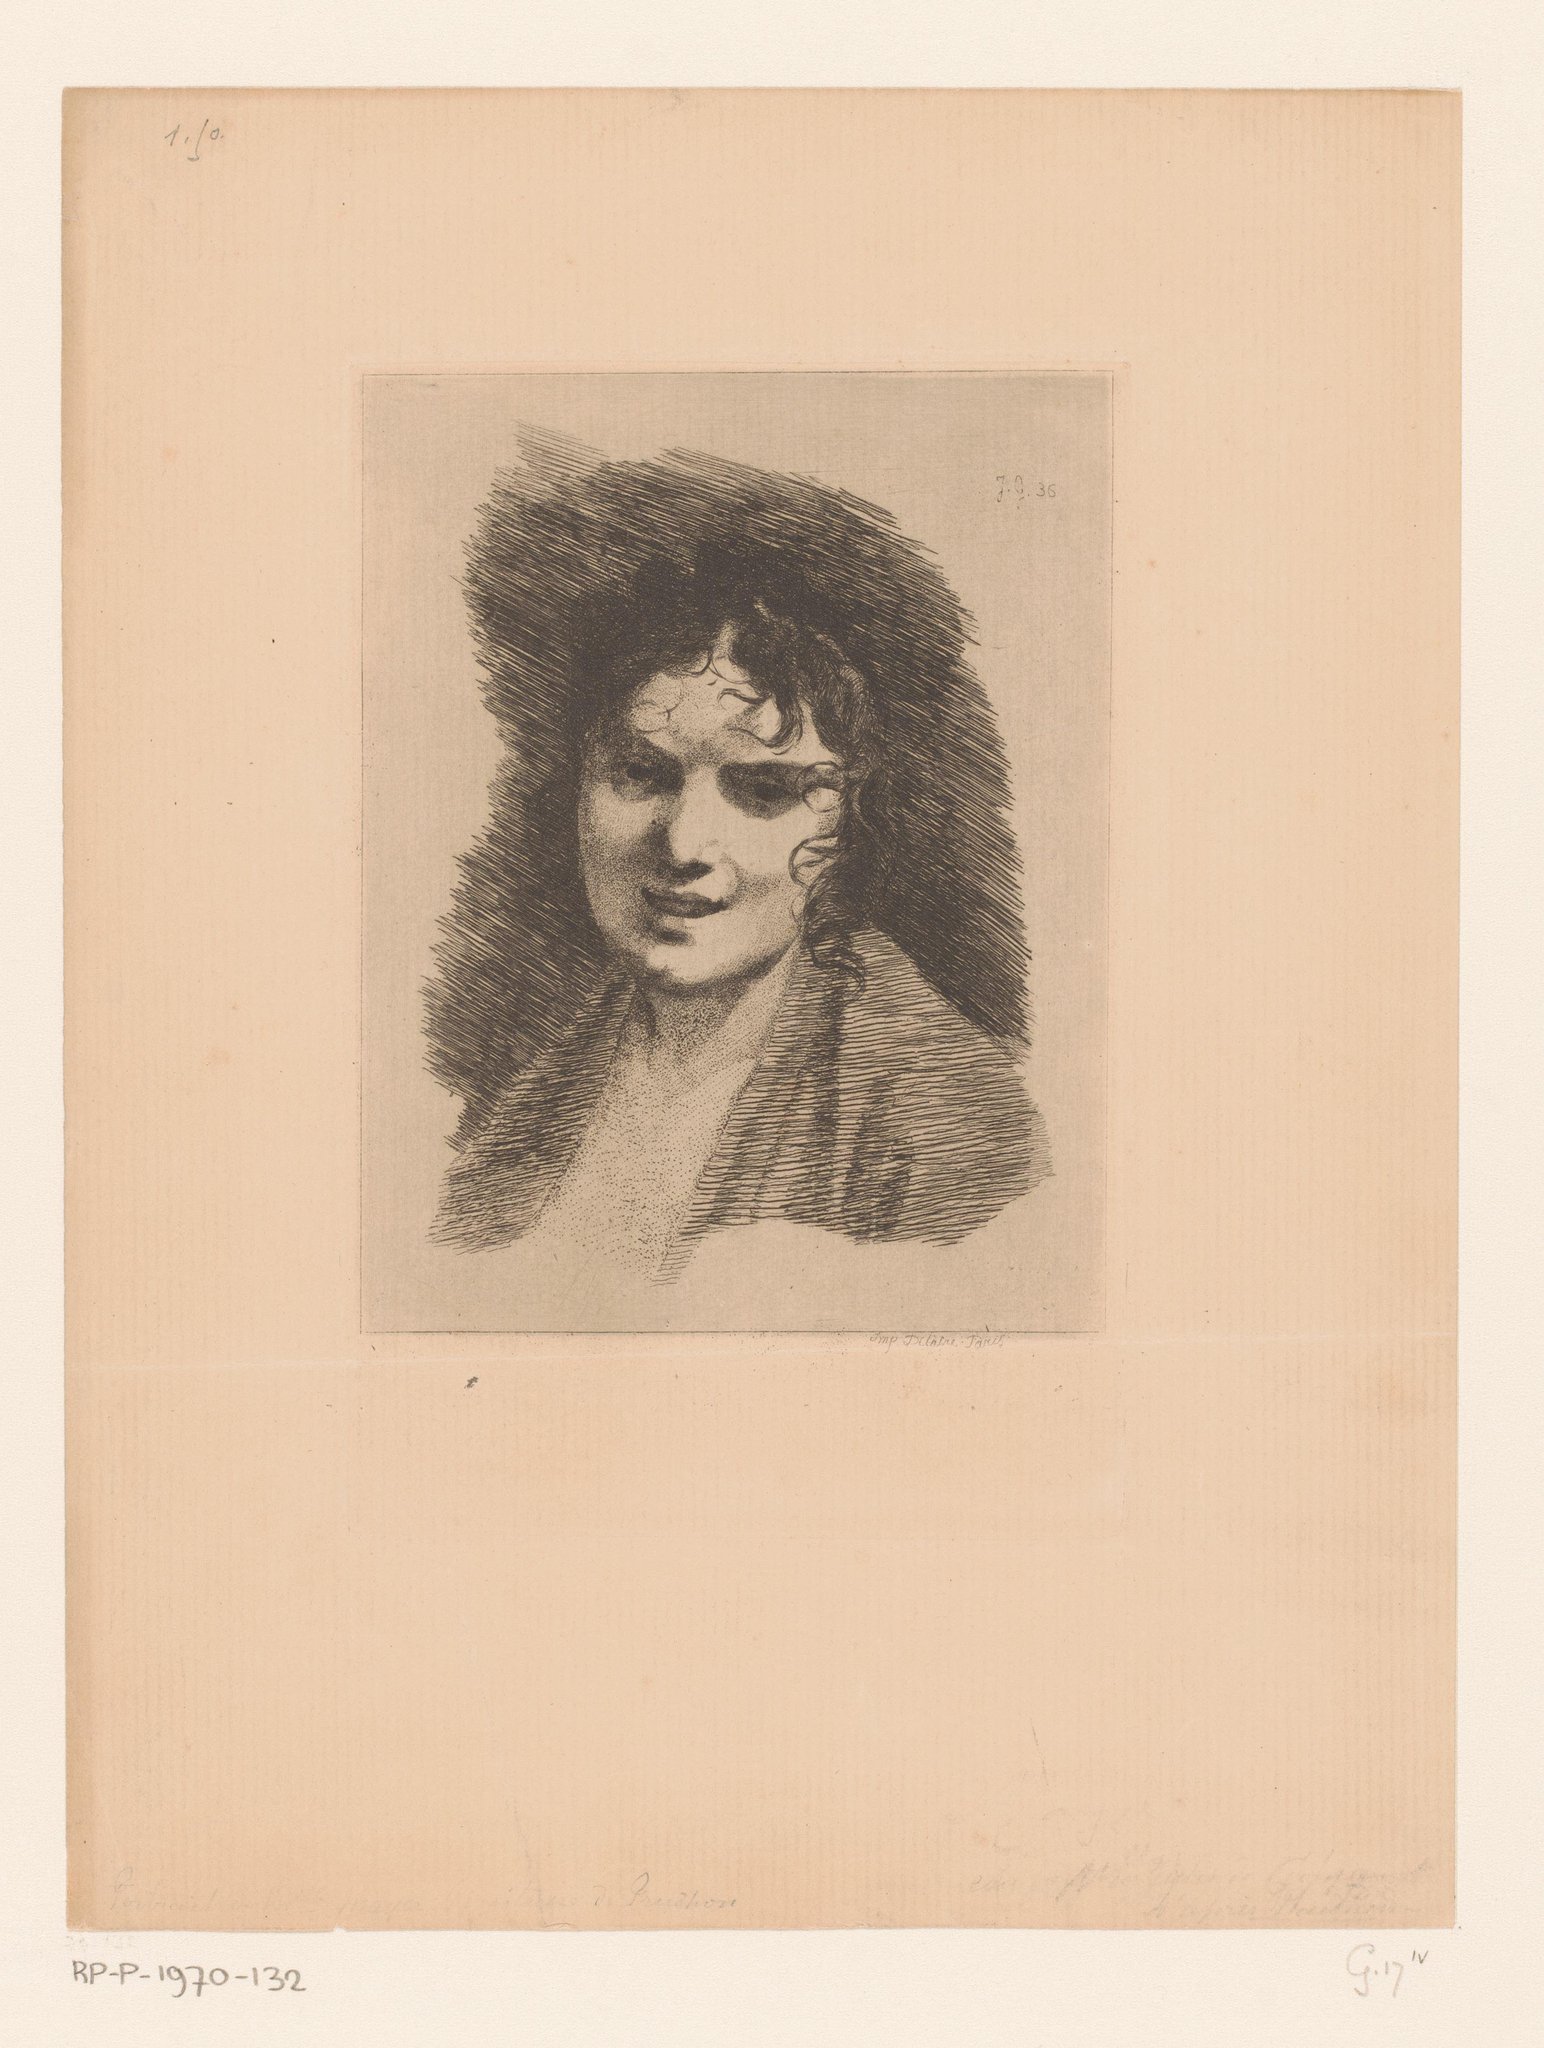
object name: print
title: Portret van Constance Mayer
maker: jules de goncourt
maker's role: print maker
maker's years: 1830-1870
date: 1860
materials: paper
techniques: etching, intaglio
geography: paris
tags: paris, artist, constance mayer, historical persons, portrait, self-portrait of painter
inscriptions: collector's mark: Lugt 2228a, collector's mark: Lugt 2760